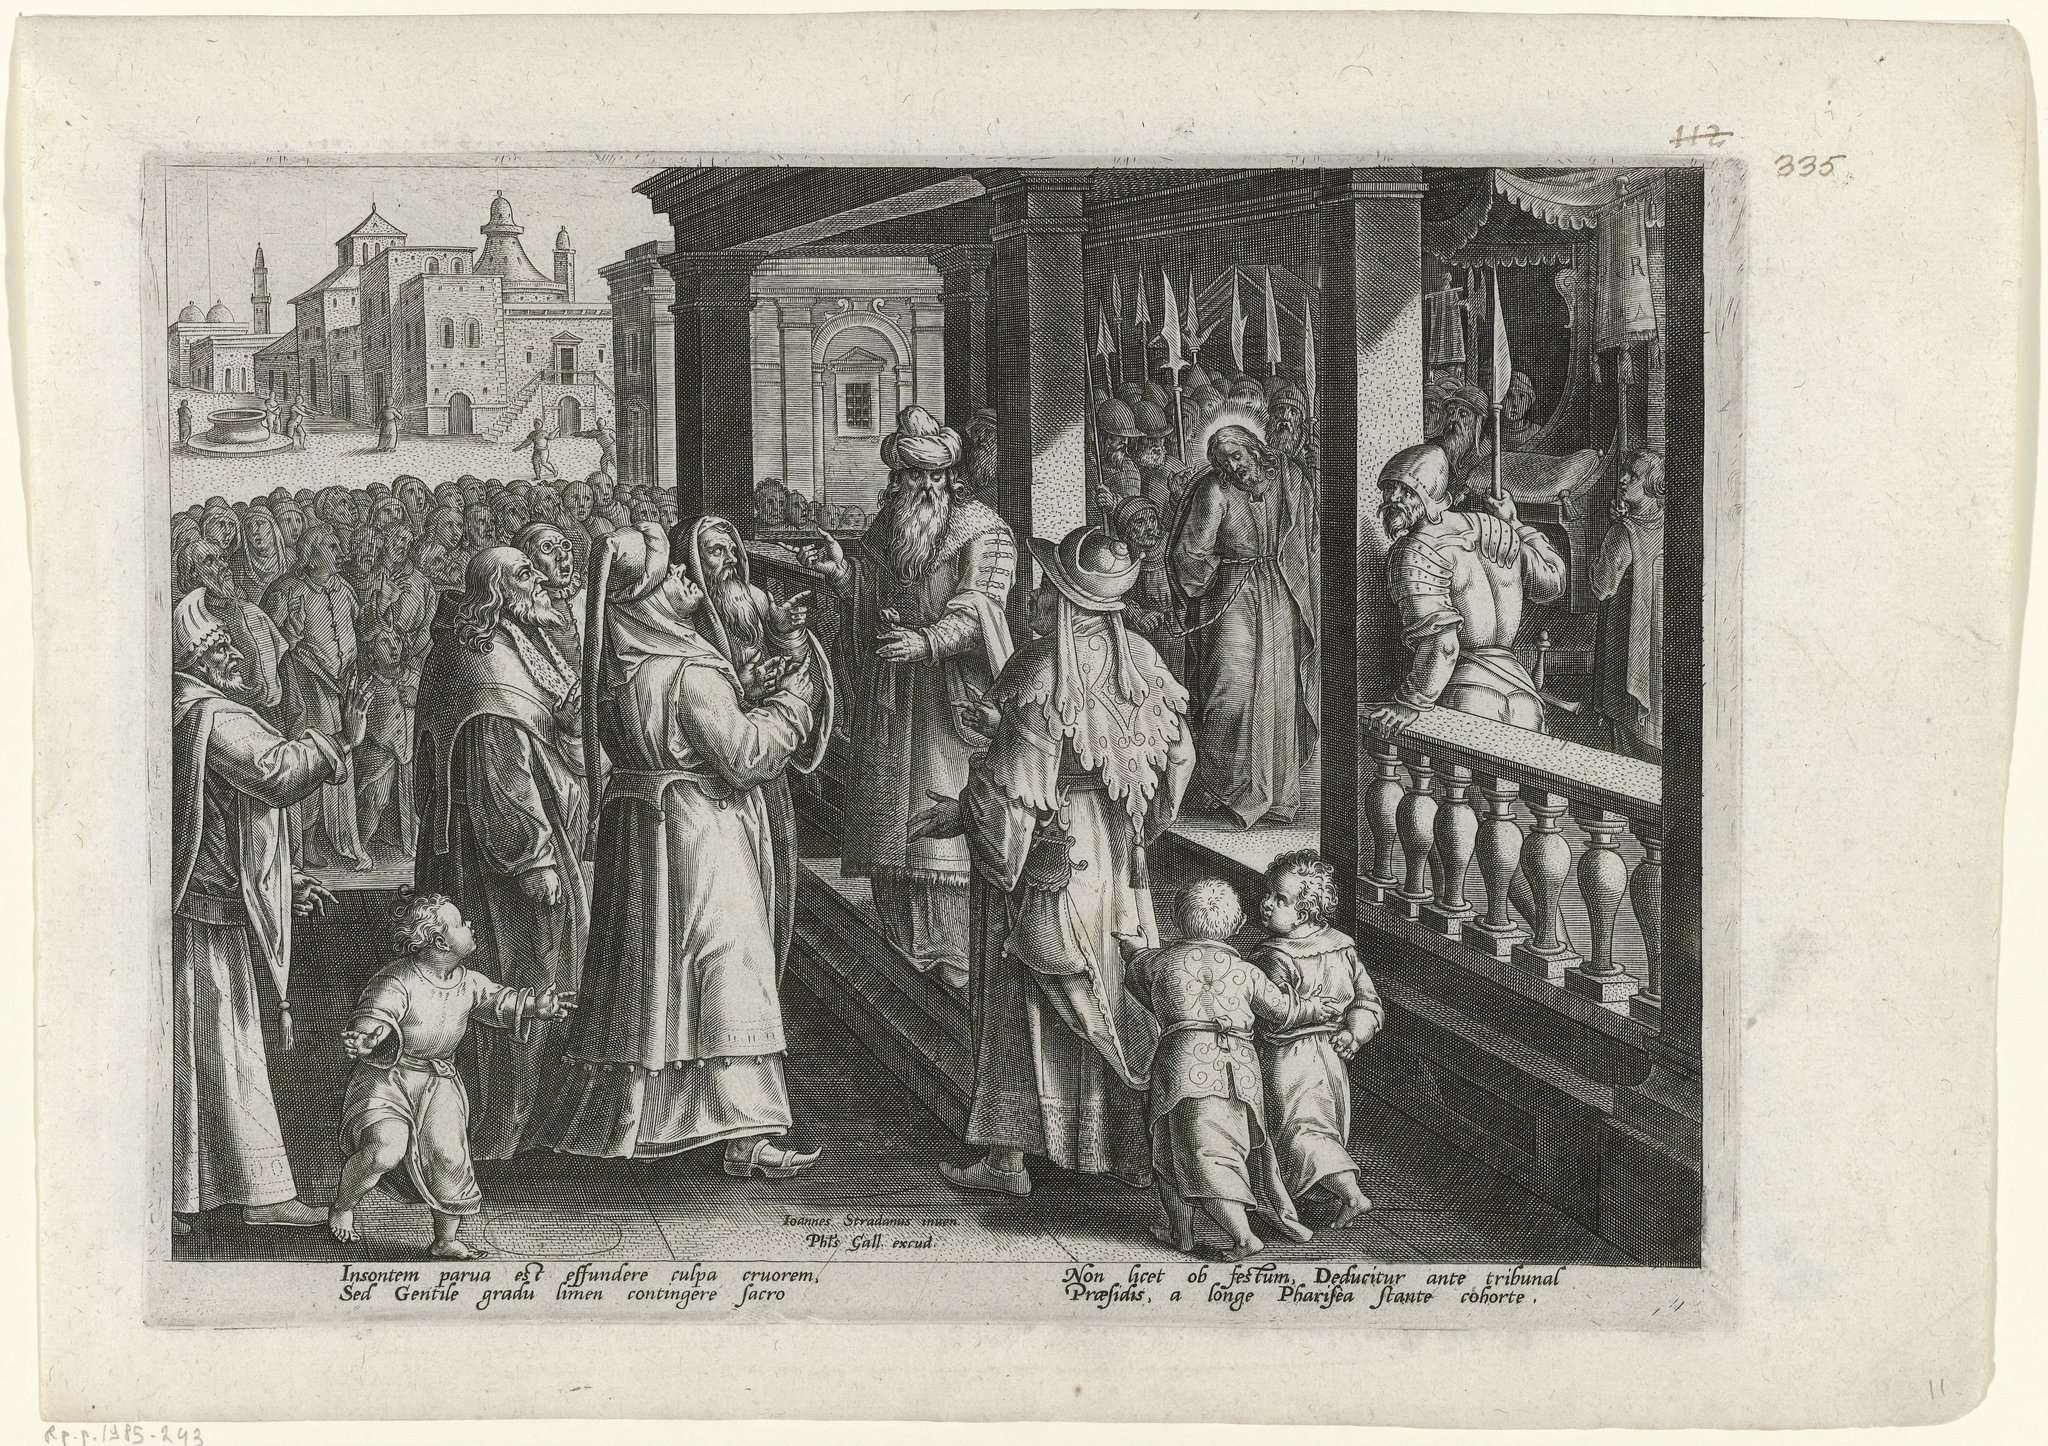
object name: print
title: Passie, dood en wederopstanding van Christus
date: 1585-1586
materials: paper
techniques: engraving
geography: antwerp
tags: pilate in debate with the jews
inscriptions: number: ‘335’, collector's mark: 2760, watermark:, collector's mark: Lugt 2228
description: Christus wordt voor Pilatus gebracht. Pilatus spreekt de menigte joden toe en verklaart Christus onschuldig (Luc.: 4-5). De prent heeft een Latijns onderschrift en maakt deel uit van een serie over het leven van Christus.